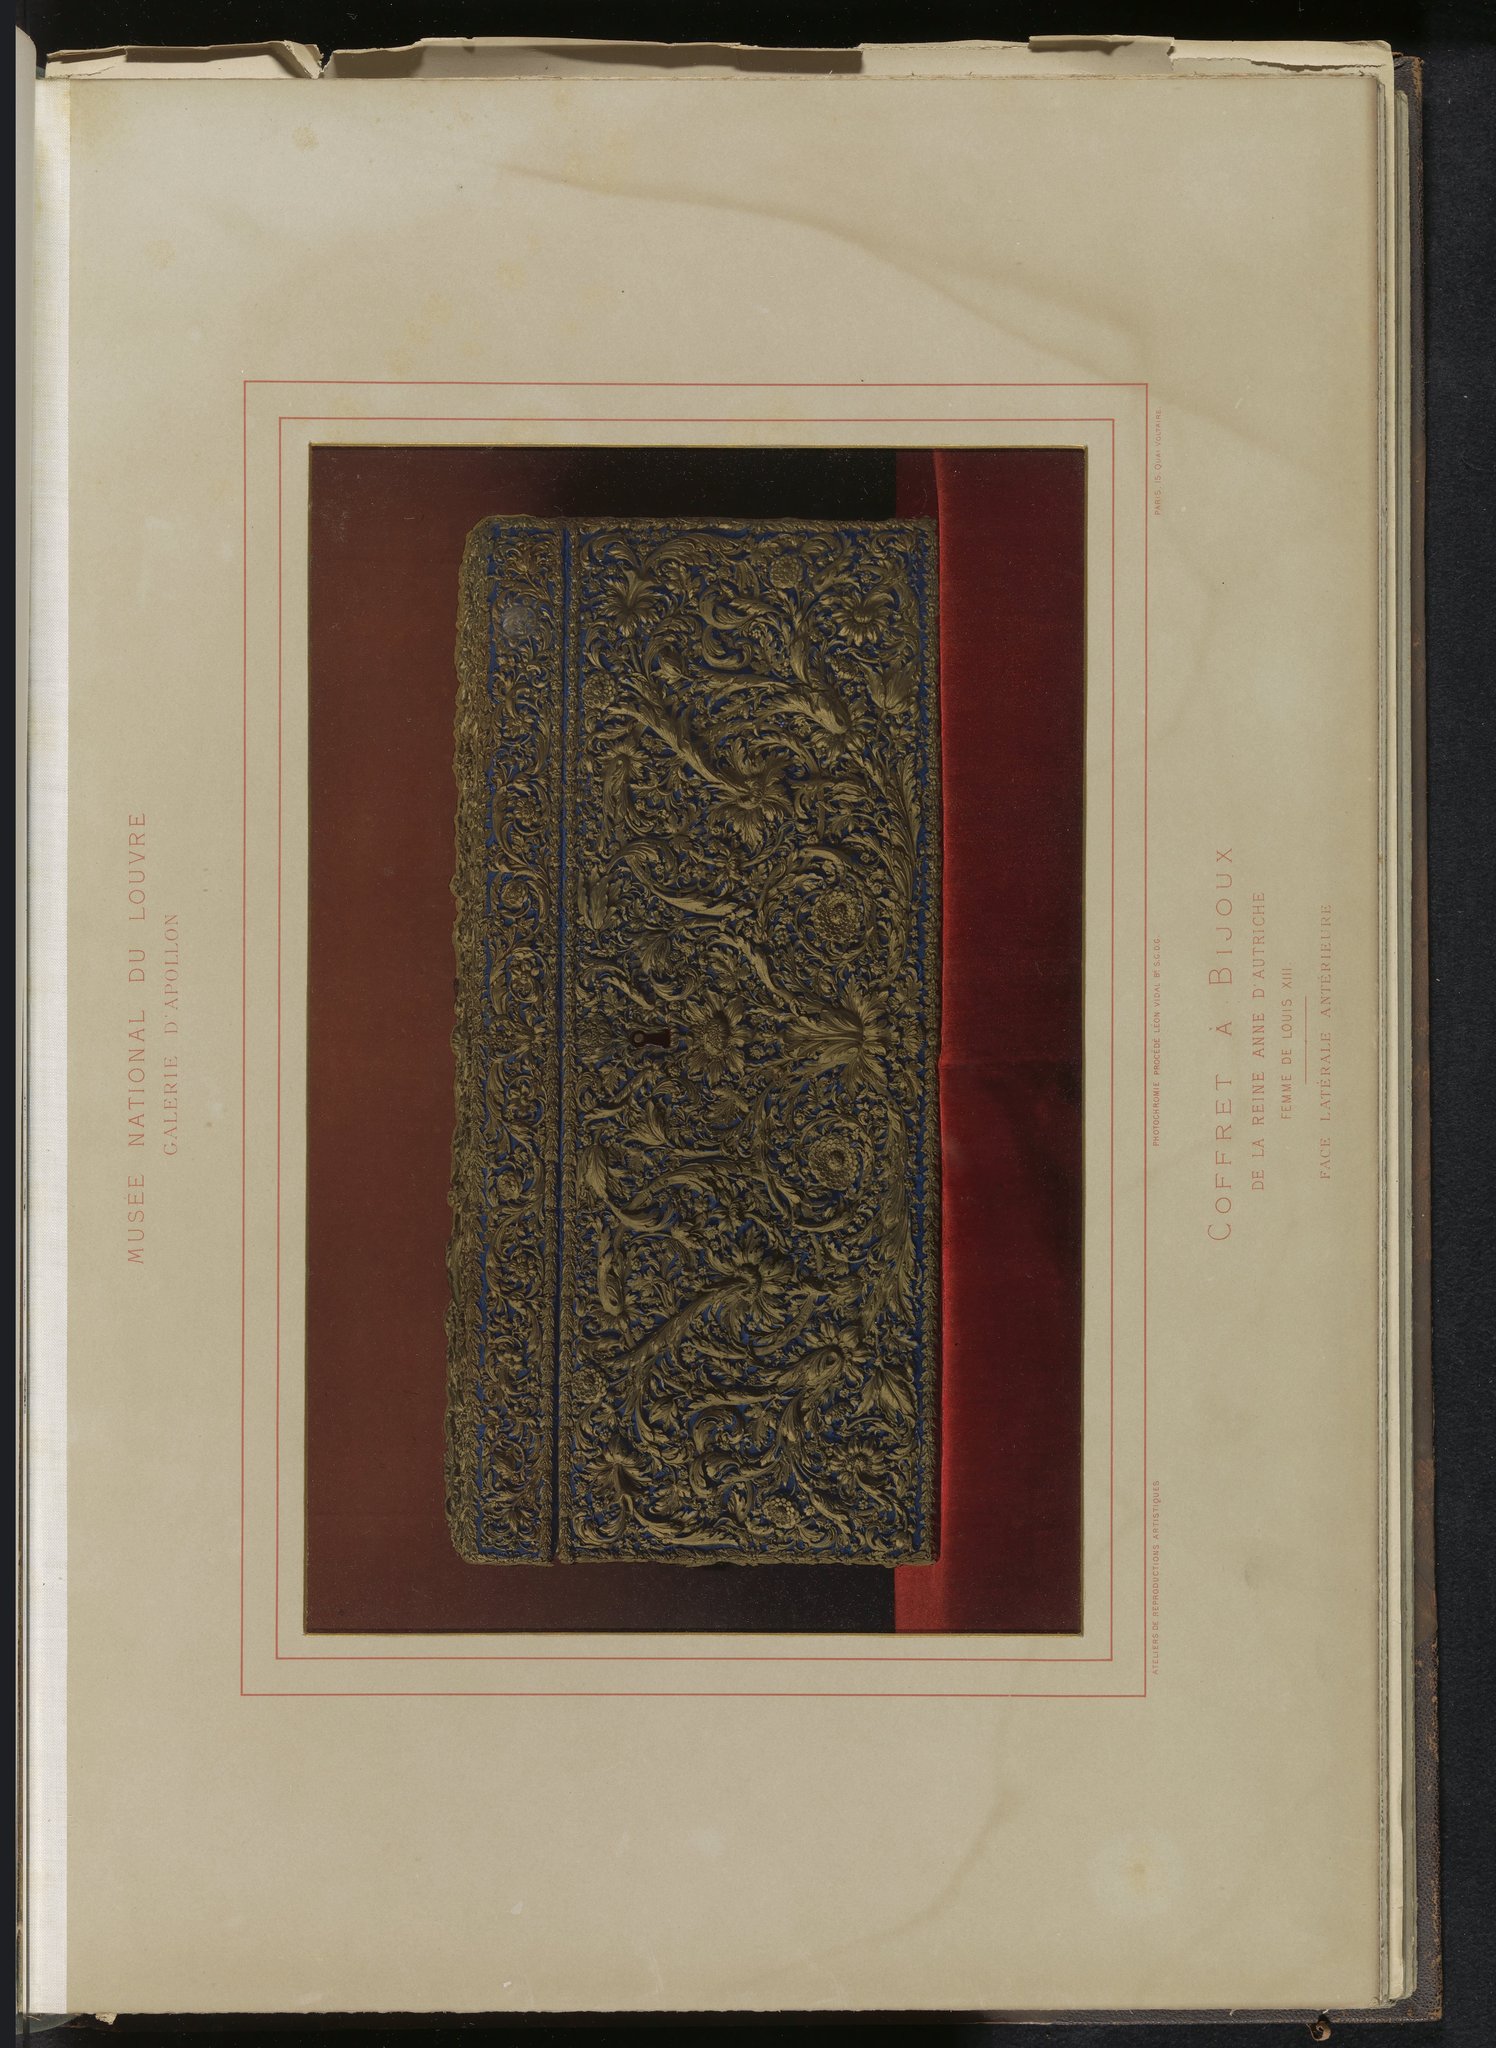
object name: page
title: Coffret à bijoux de la reine Anne d'Autriche femme de Louis XIII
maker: léon vidal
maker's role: fotograaf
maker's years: 1833-1906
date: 1876-1883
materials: paper, photographic process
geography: paris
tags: floral interlace ~ ornament, chasing, embossing (industrial process), jewel-box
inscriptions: inscription: ‘face latérale antérieure’, inscription: ‘ateliers de reproductions artistiques’